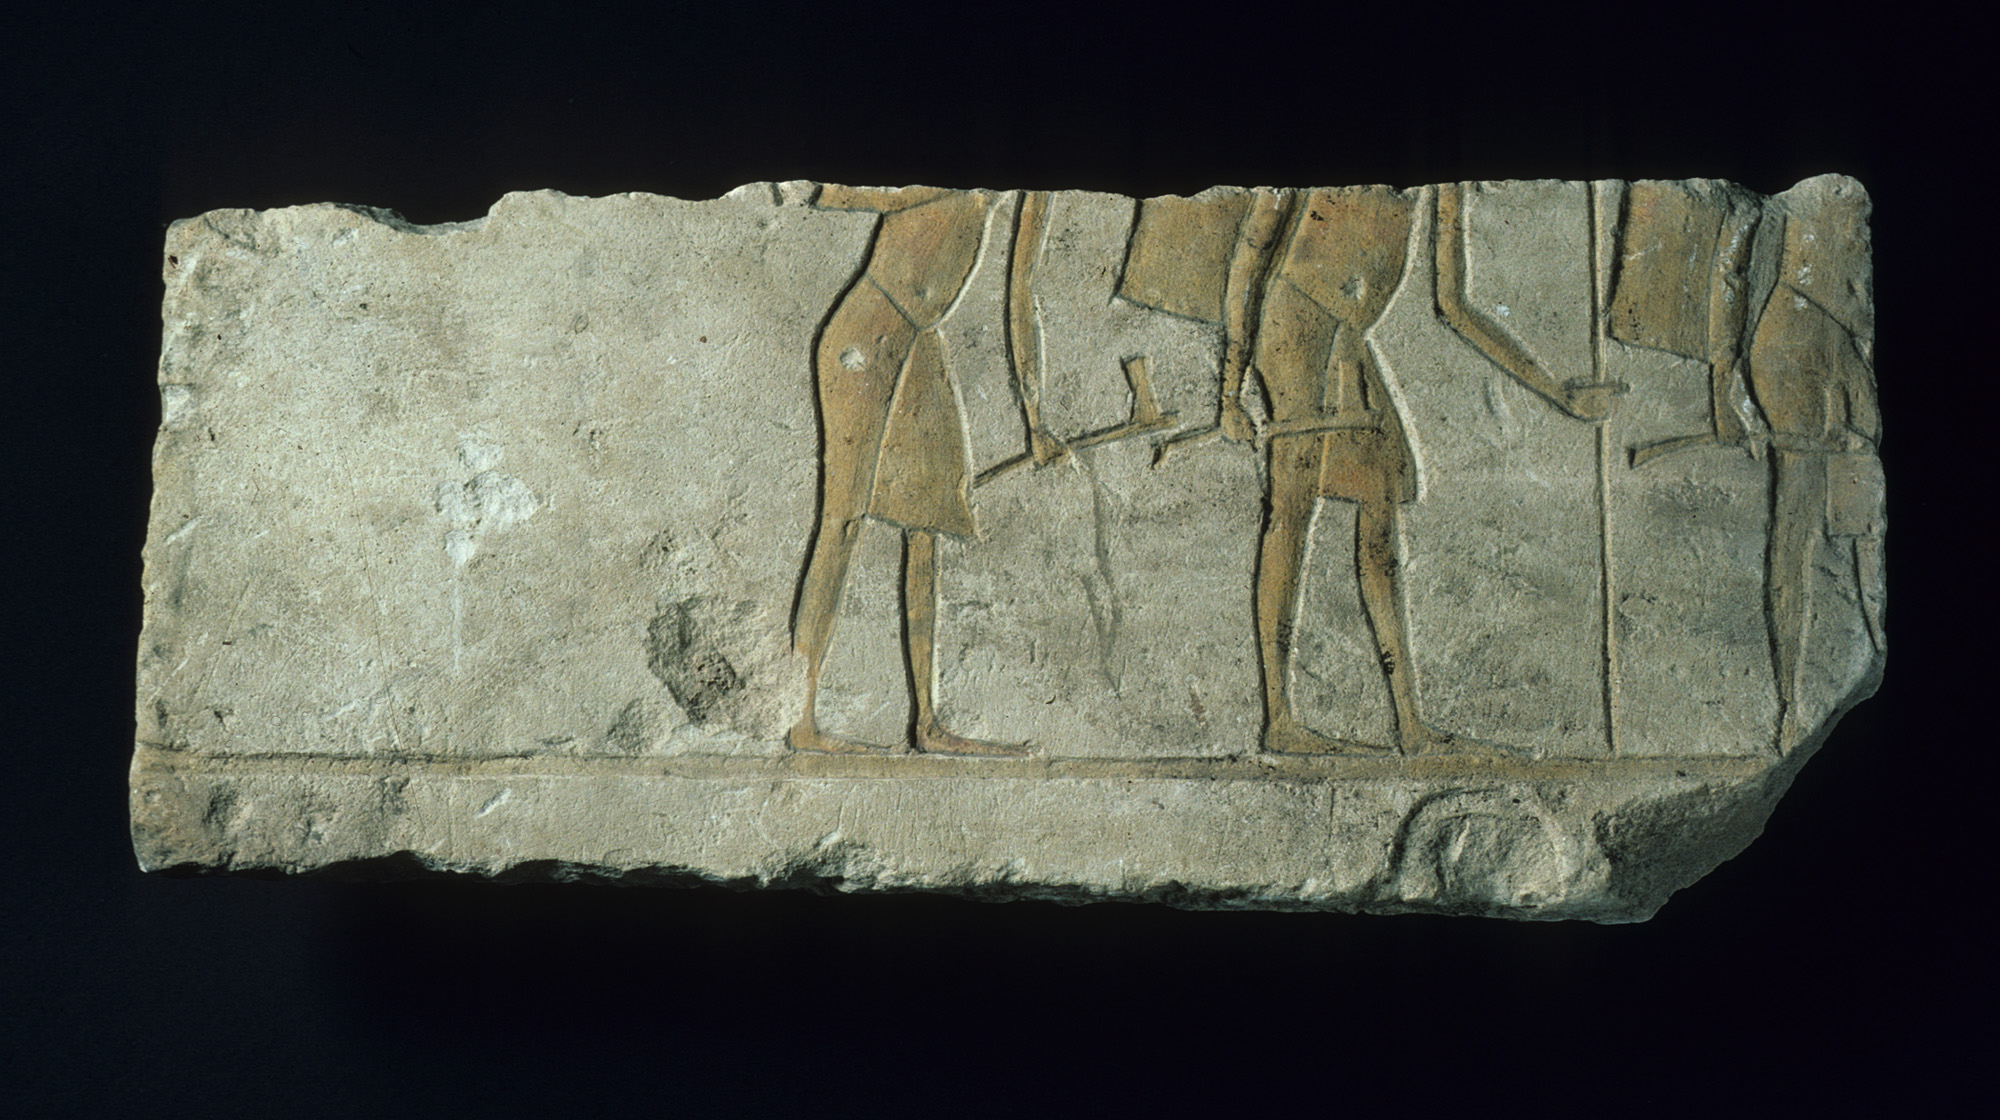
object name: talatat, three soldier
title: Relief with three soldiers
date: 1353-1336 BCE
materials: limestone, paint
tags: soldiers,men